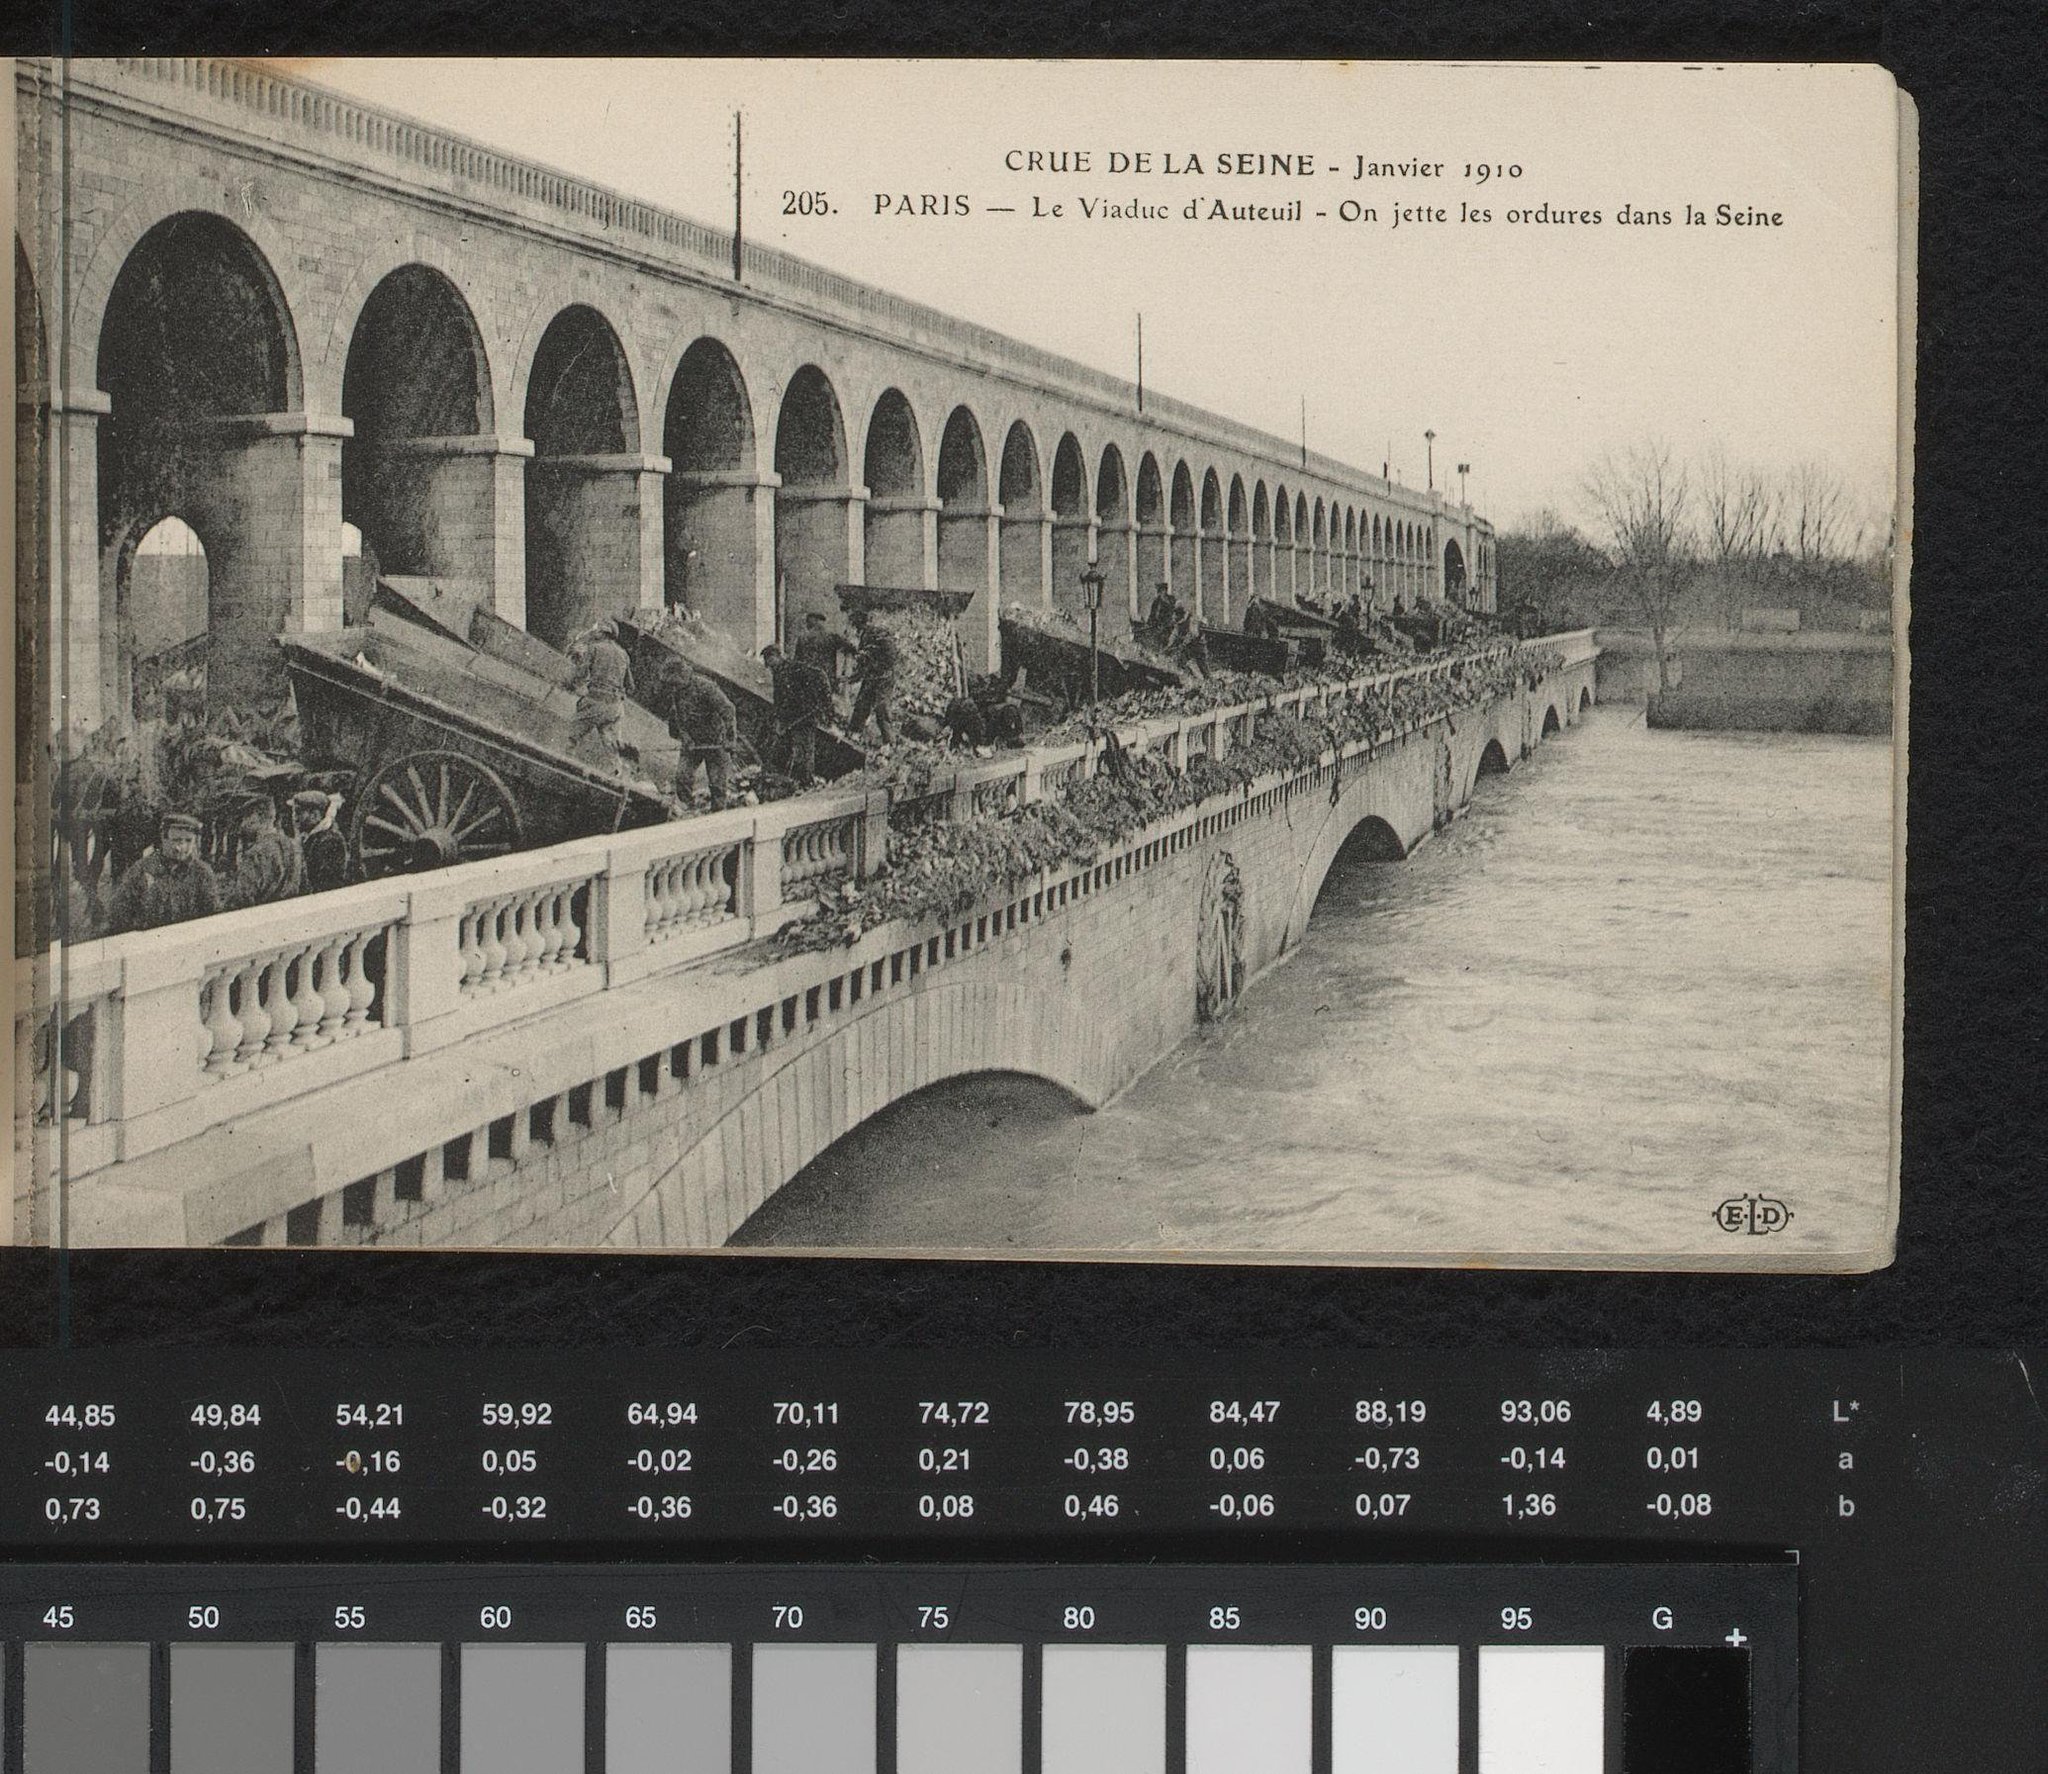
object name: ansichtkaart, prentbriefkaart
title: Janvier 1910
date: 1910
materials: cardboard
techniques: photograph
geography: paris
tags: flood, bridge, city-view, and landscape with man-made constructions (+ city(-scape) with figures, staffage)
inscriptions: date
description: Prentbriefkaart maakt deel uit van een album.